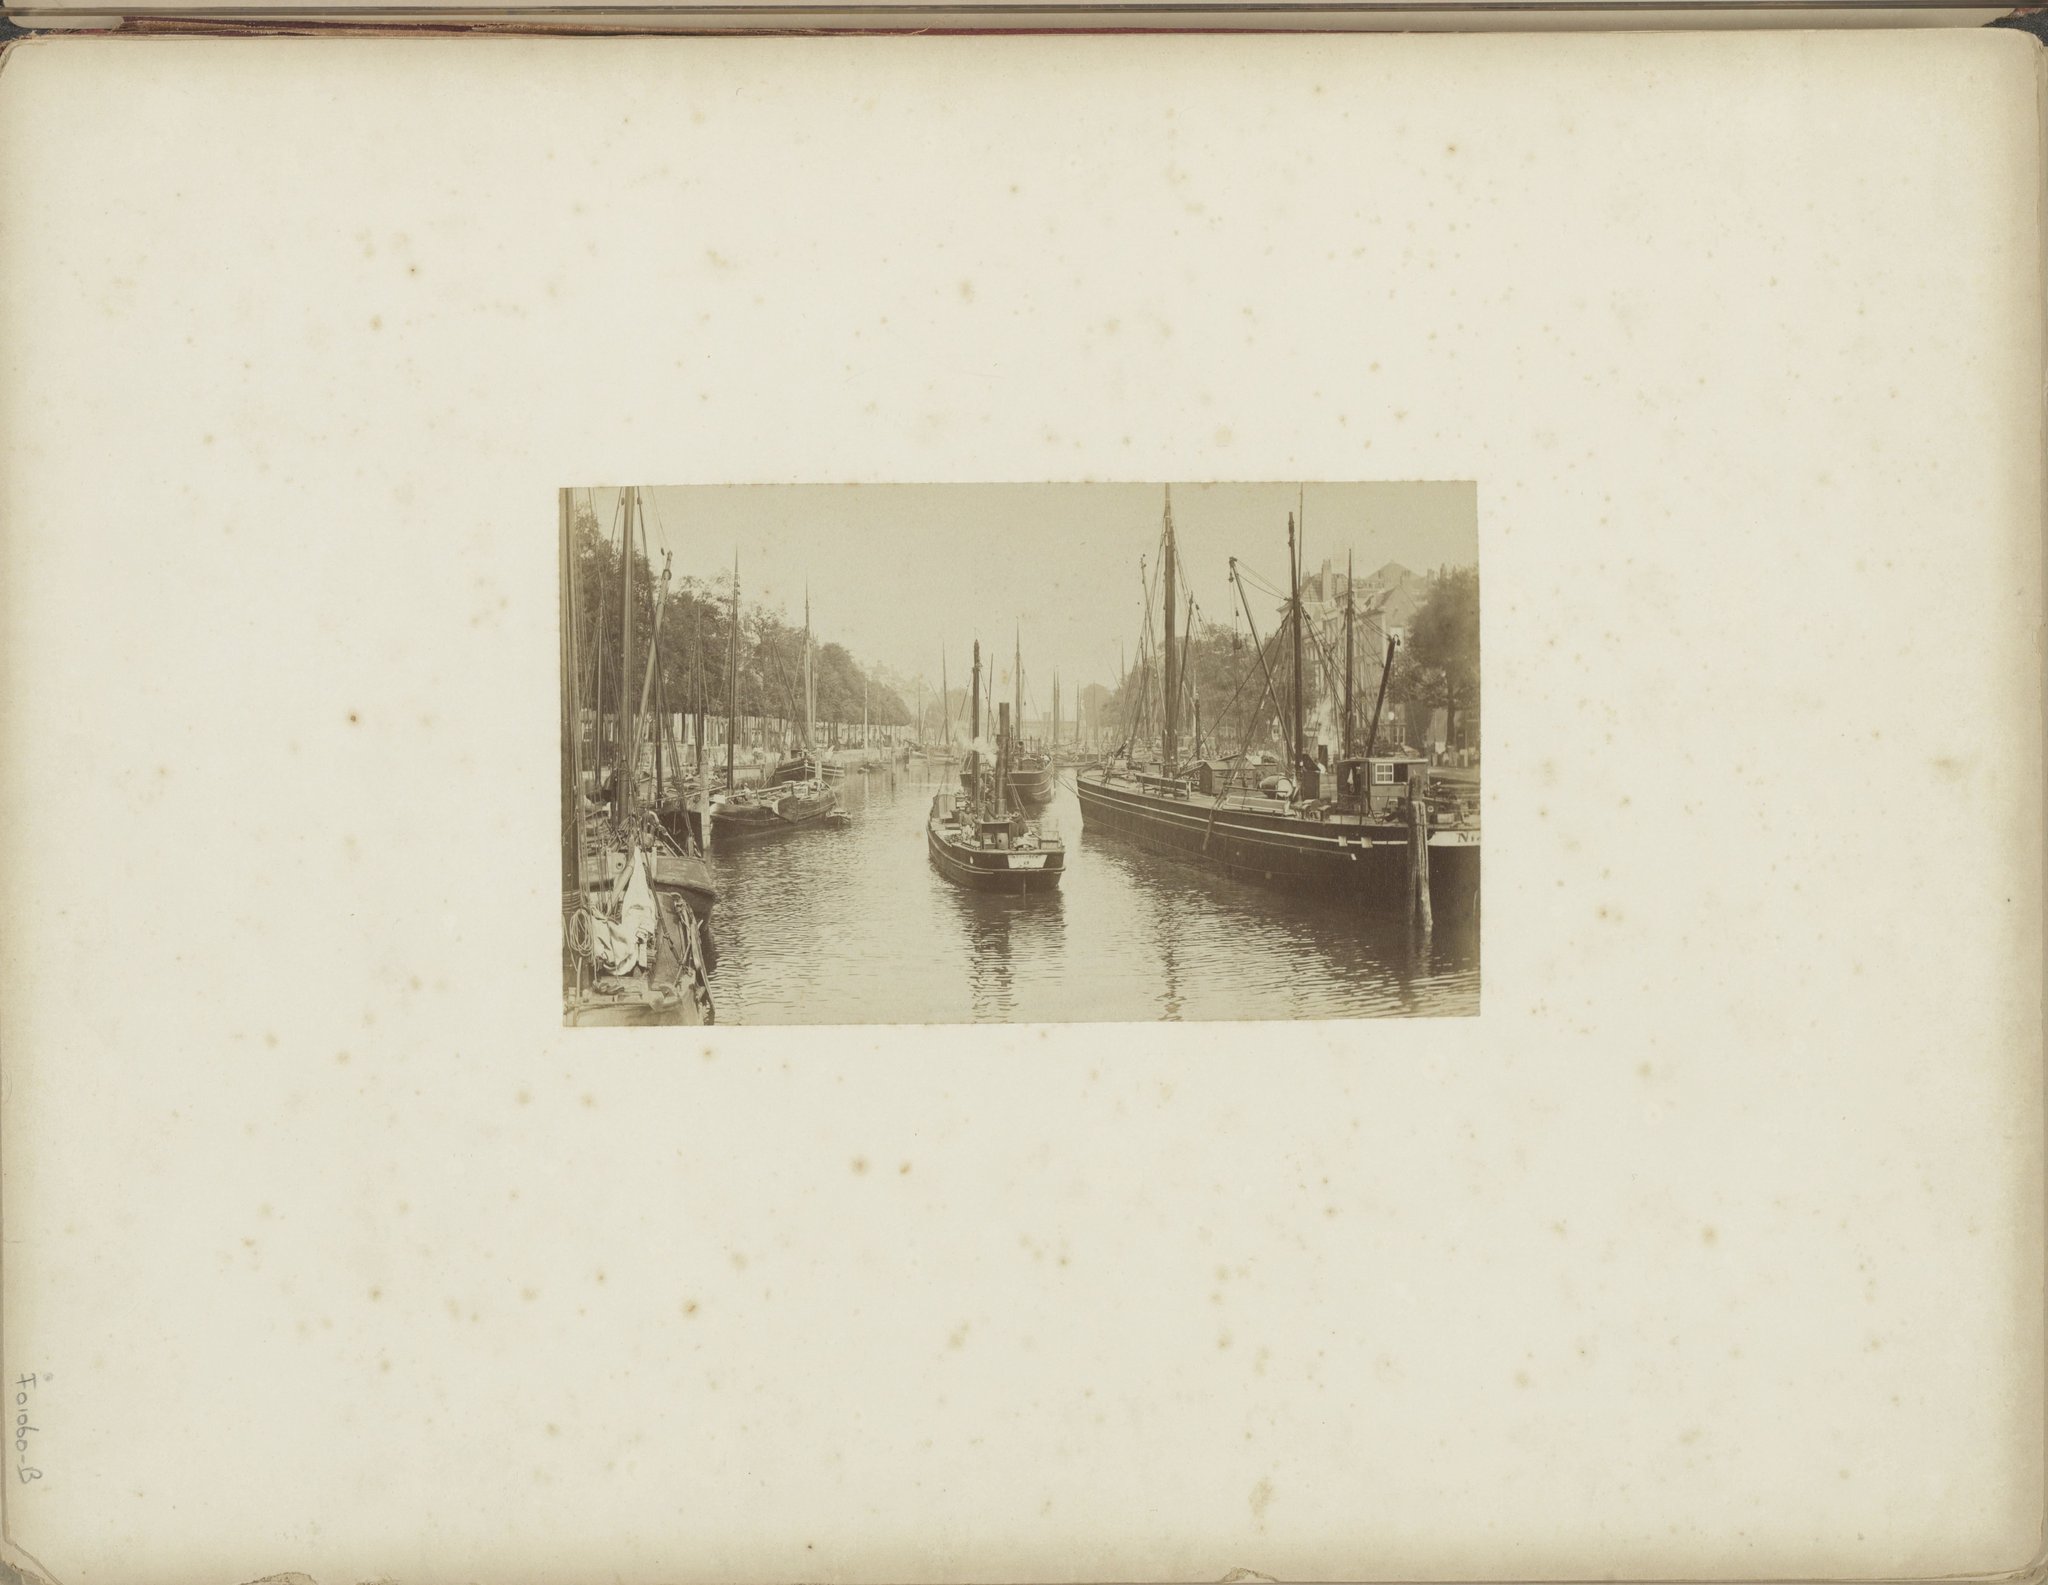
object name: photograph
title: Schepen in de Wijnhaven te Rotterdam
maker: Anonymous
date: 1880-1900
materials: photographic support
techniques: albumen print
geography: wijnhaven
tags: harbour (+ view ~ vehicle, ship, etc.), steamship, motorship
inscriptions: inscription: ‘Wijnhaven’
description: Onderdeel van Fotoalbum met stadsgezichten van Rotterdam.